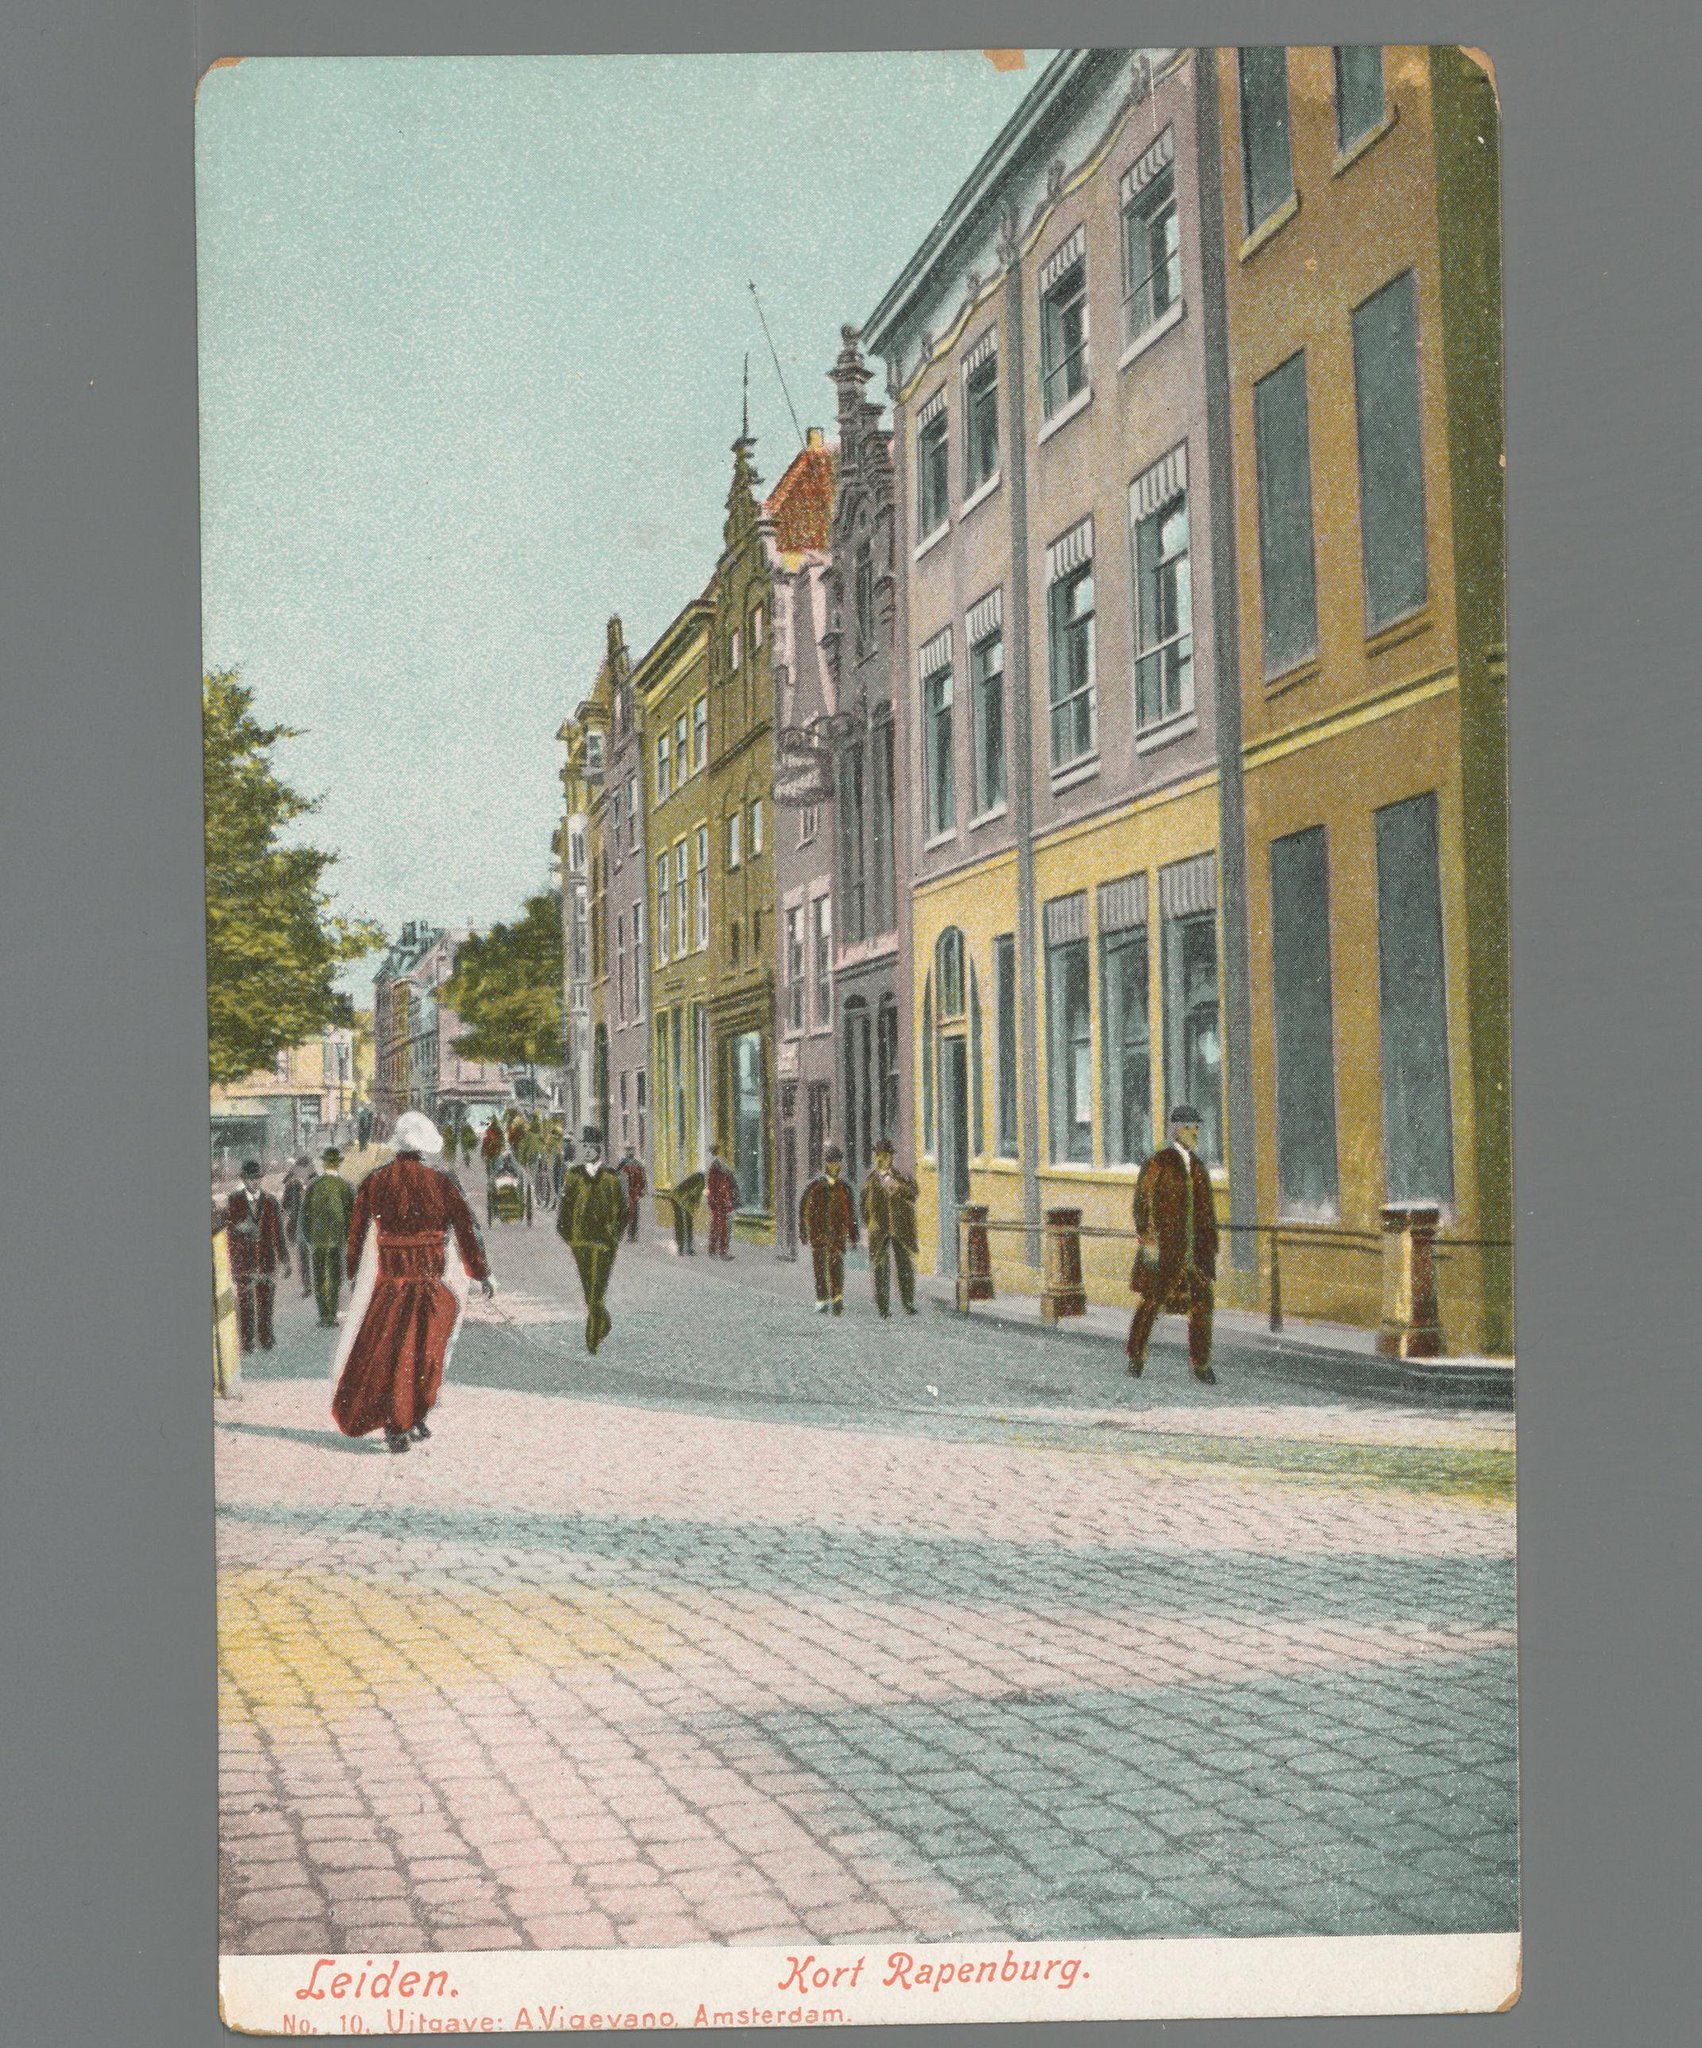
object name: photomechanical print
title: Leiden. Kort Rapenburg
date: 1892-1905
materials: cardboard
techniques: lithograph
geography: leiden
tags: street, leiden